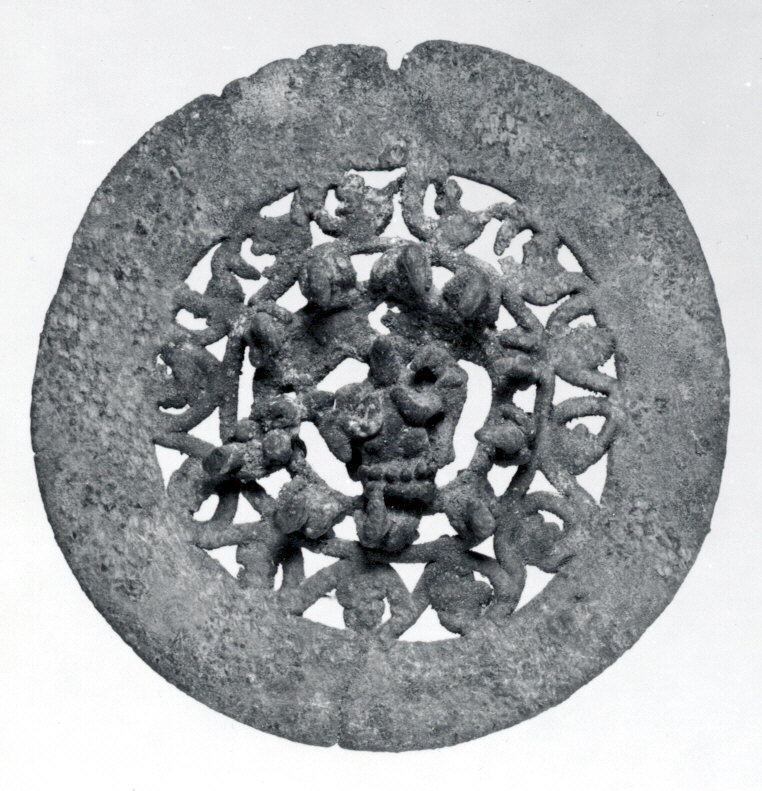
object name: disk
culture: moche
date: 201-500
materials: copper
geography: peru